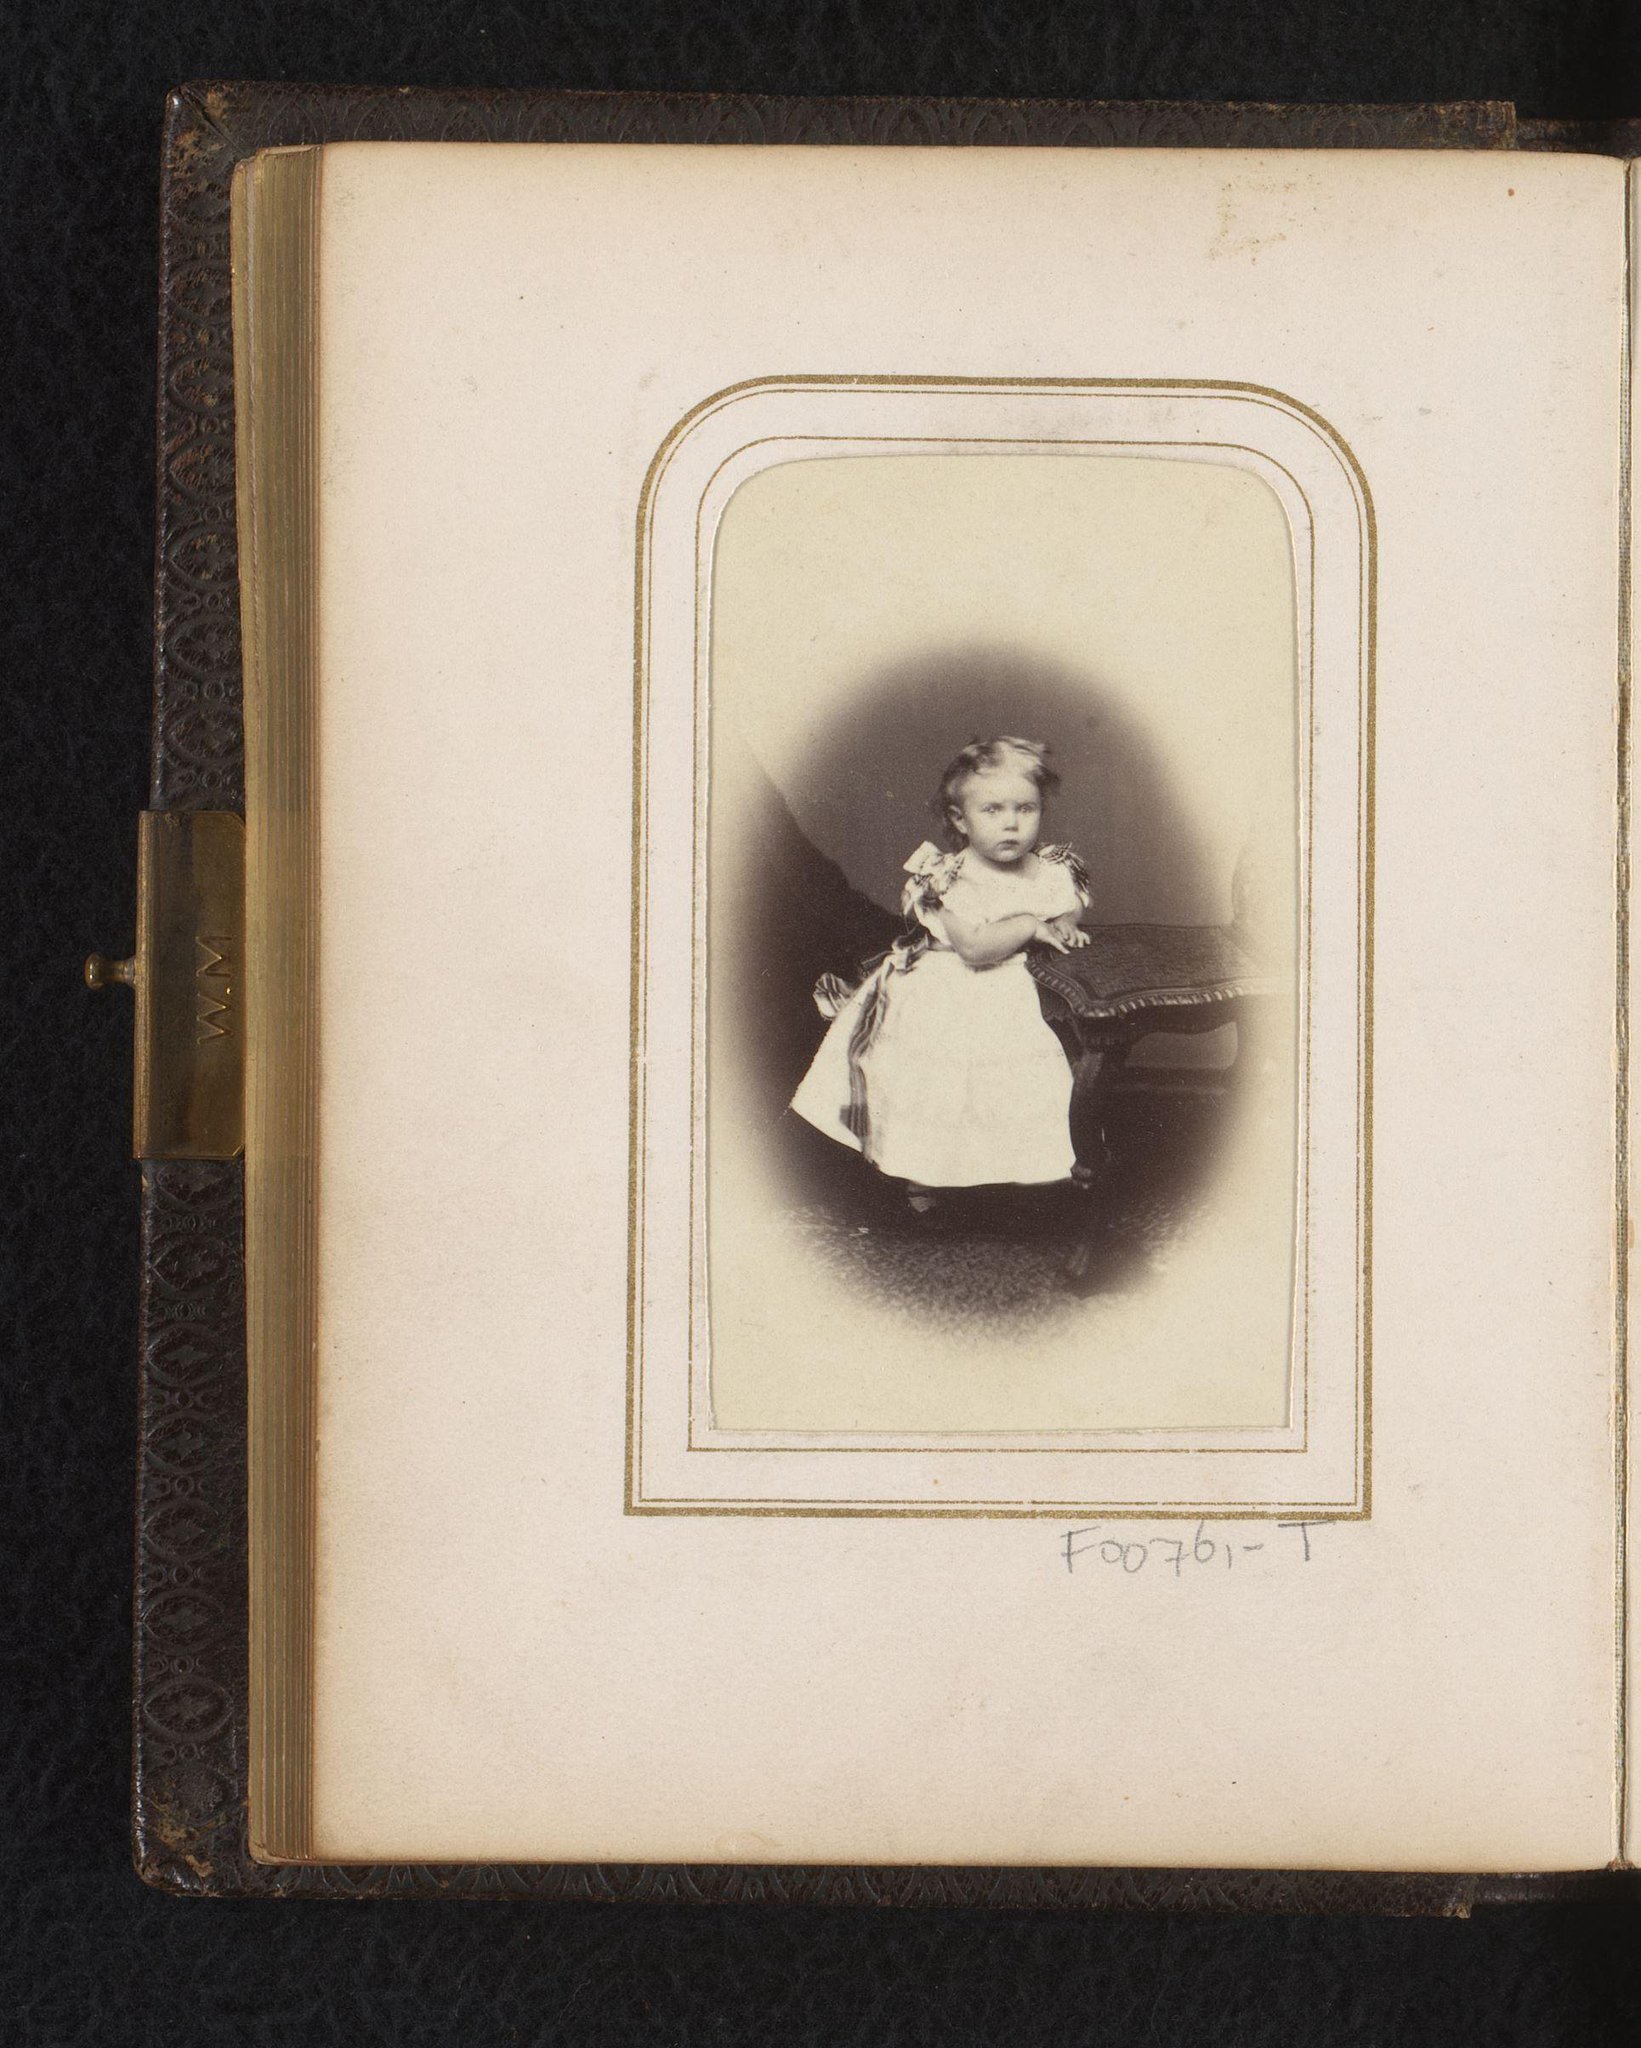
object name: carte de visite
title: Portret van een meisje, staand bij een stoel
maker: john pouncy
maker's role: fotograaf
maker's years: 1818-1894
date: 1867-1880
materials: cardboard, photographic support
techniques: albumen print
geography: dorchester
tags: girl (child between toddler and youth)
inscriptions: inscription: ‘Pouncy, Dorchester/ Paris 1867 (...)’